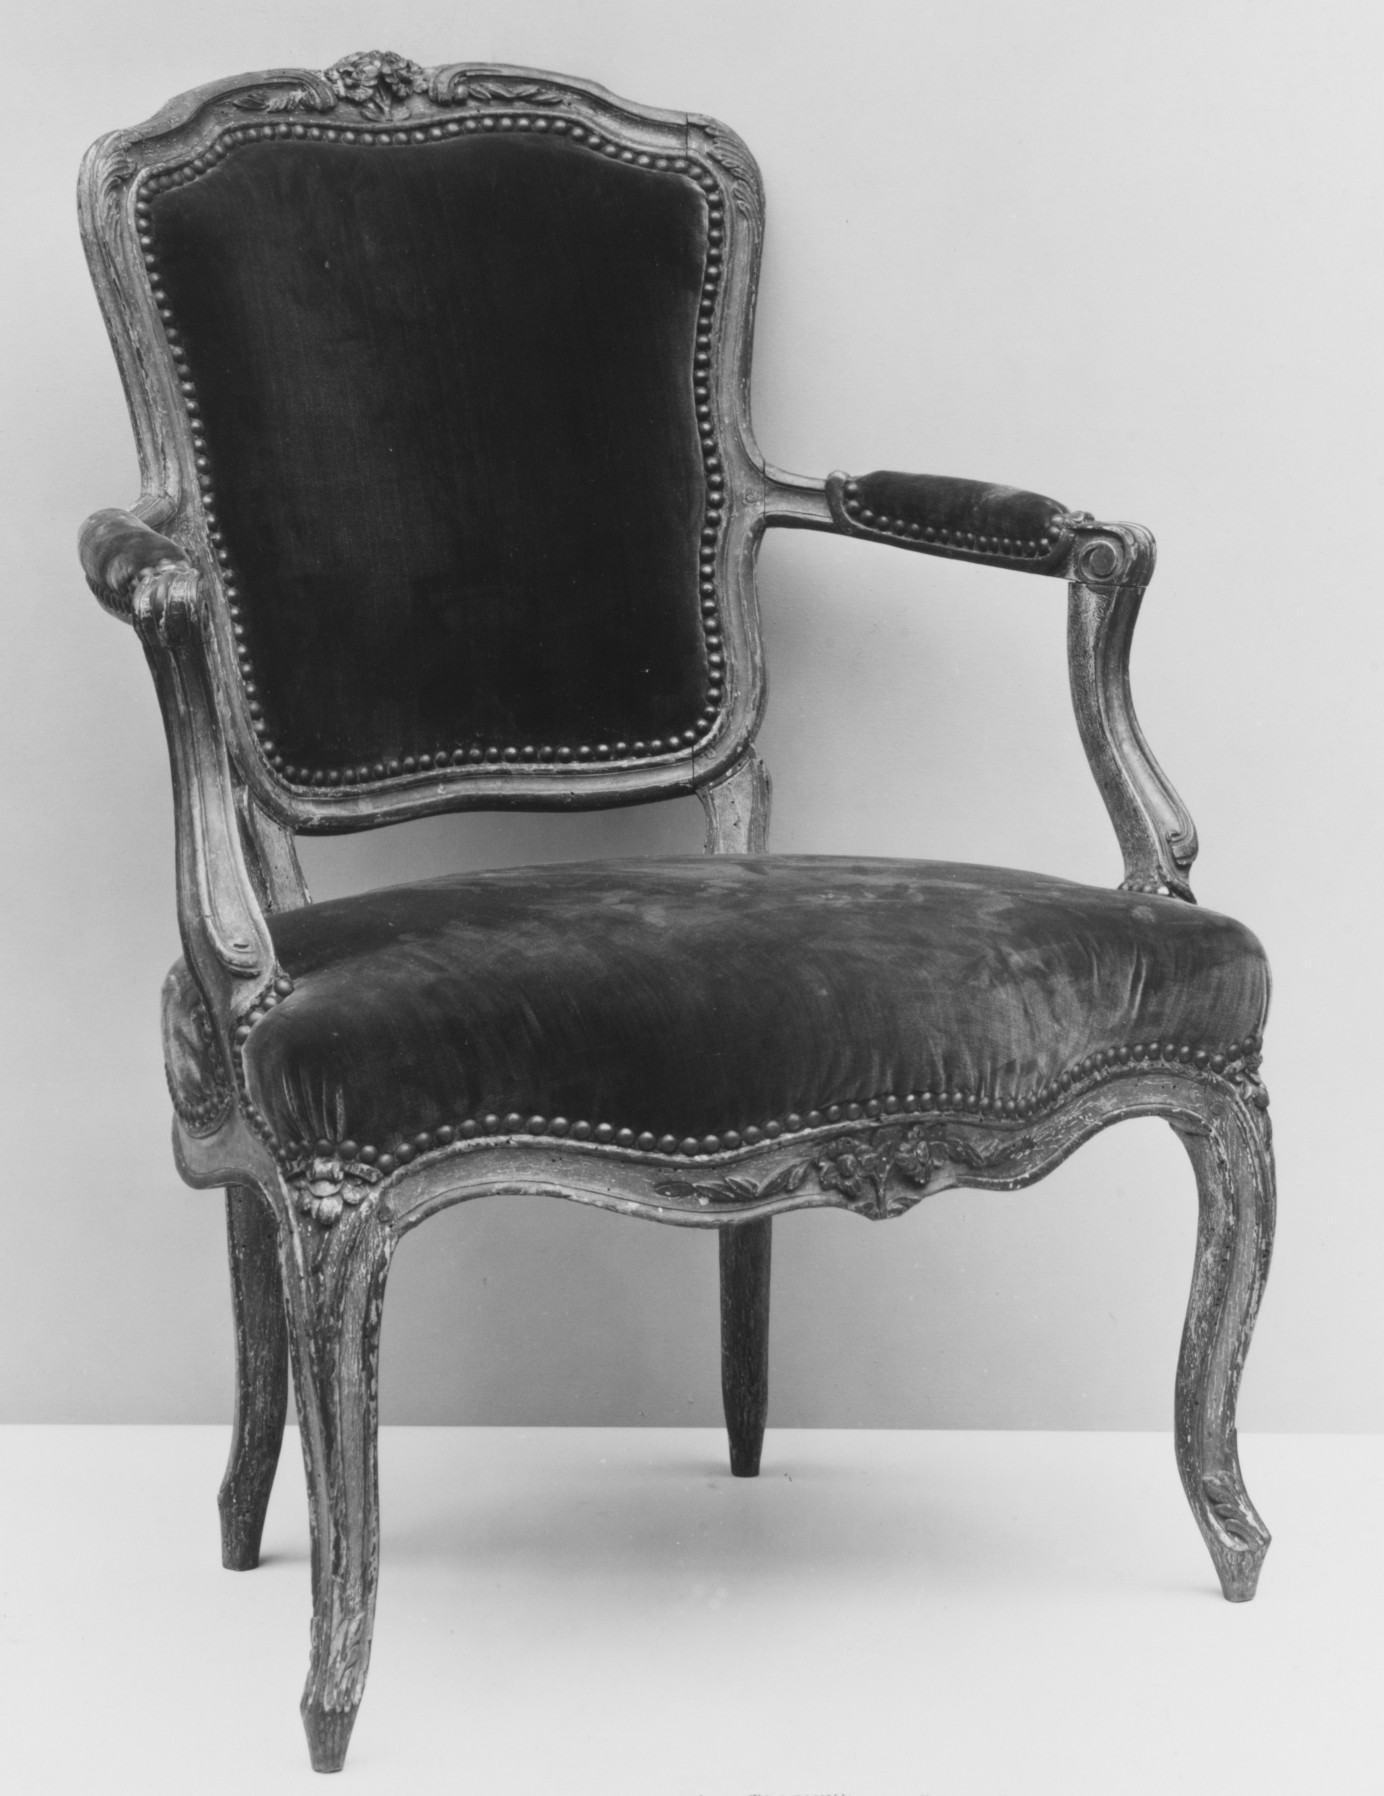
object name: armchair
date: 1734-1766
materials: wood, velvet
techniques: carving, painting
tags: flowers